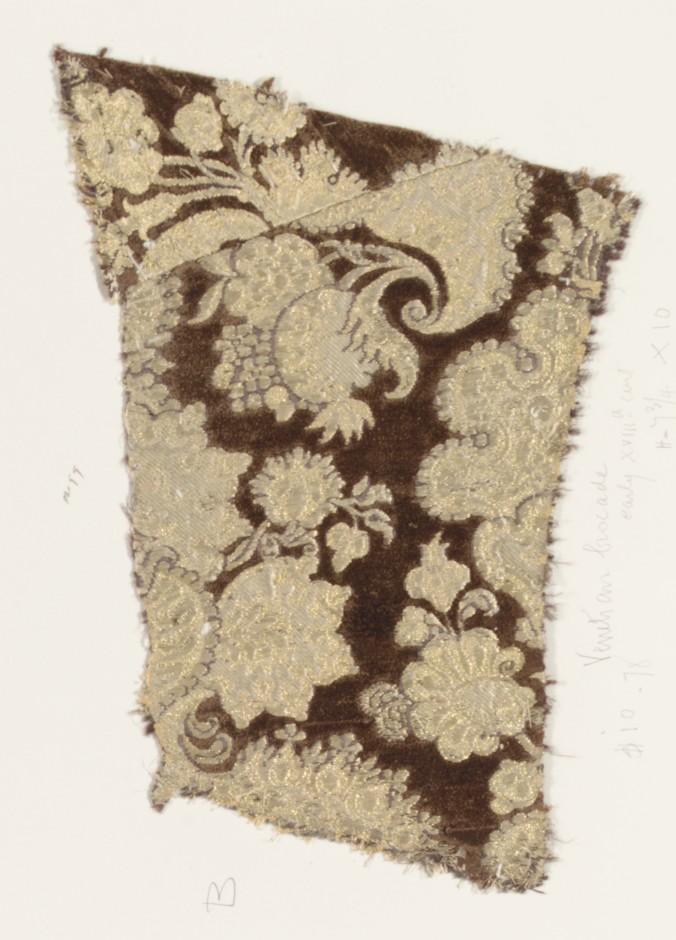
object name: fragment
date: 1701-1733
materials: metal thread, silk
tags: flowers